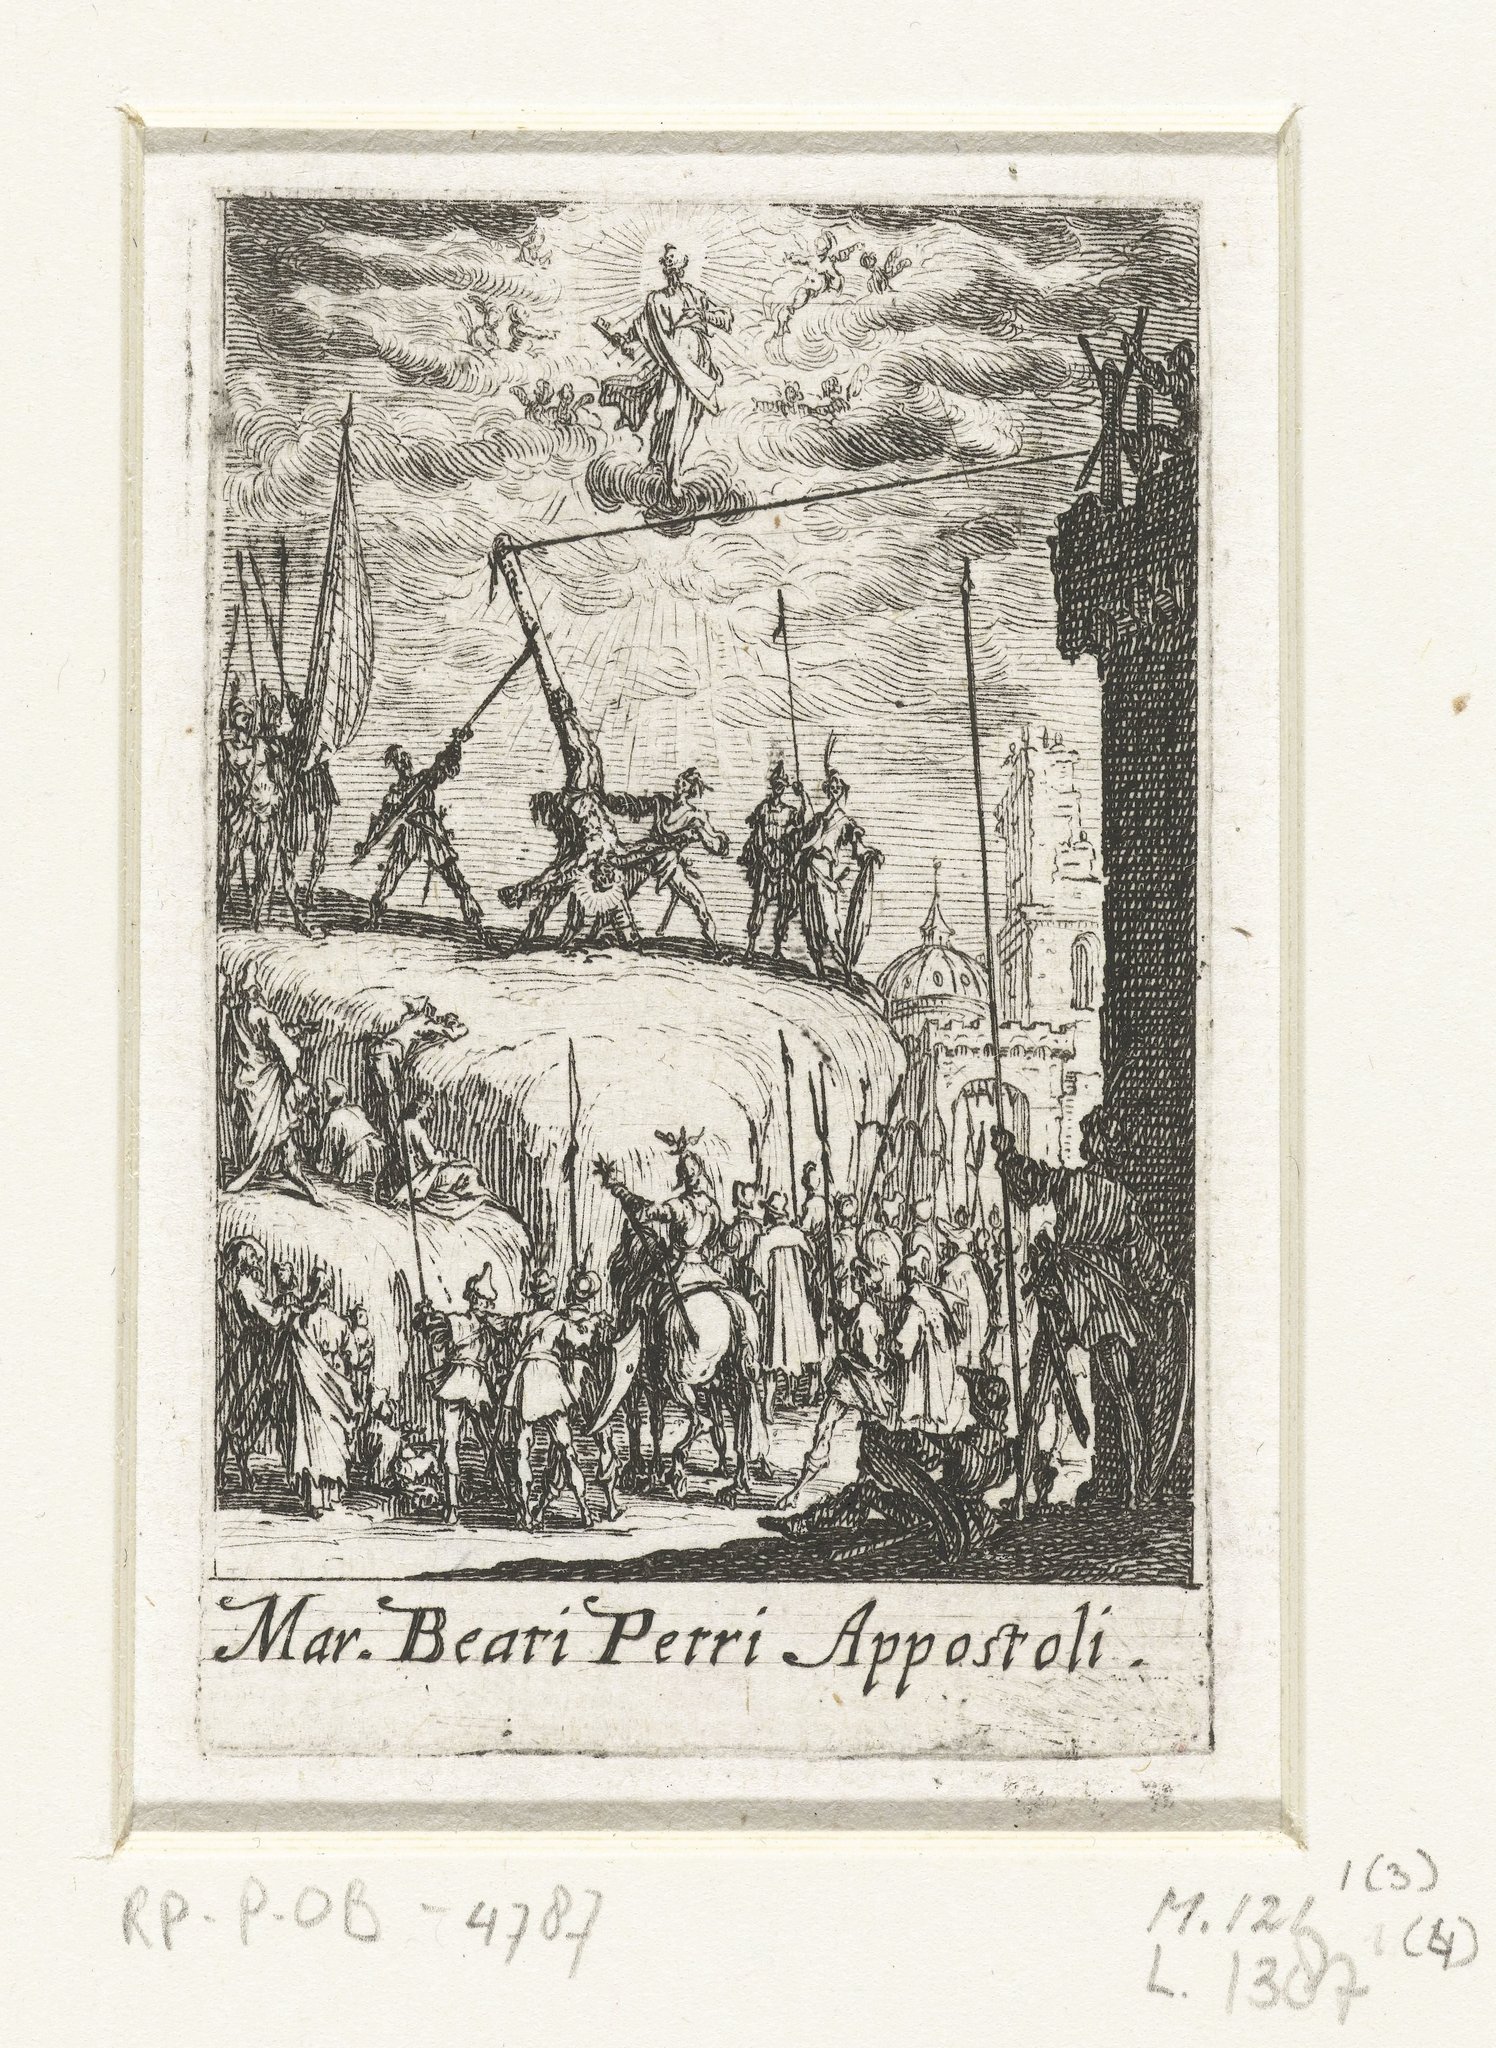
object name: print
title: De kleine apostelen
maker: jacques callot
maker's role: draughtsman, print maker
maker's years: 1592-1635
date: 1632-1634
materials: paper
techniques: etching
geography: nancy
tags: peter crucified upside down, the apostle peter, first bishop of rome; possible attributes: book, cock, (upturned) cross, (triple) crozier, fish, key, scroll, ship, tiara - martyrdom, suffering, misfortune, death of male saint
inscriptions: collector's mark: Lugt 240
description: Petrus wordt ondersteboven gekruisigd in het bijzijn van vele soldaten. Boven deze scène is Petrus nogmaals afgebeeld, op een wolk in de hemel, een sleutel in de hand. Onder de voorstelling een onderschrift in Latijn. Deze prent is onderdeel van een reeks van 16 prenten, bestaande uit een titelblad en 15 voorstellingen van de martelingen die de apostelen hebben ondergaan.